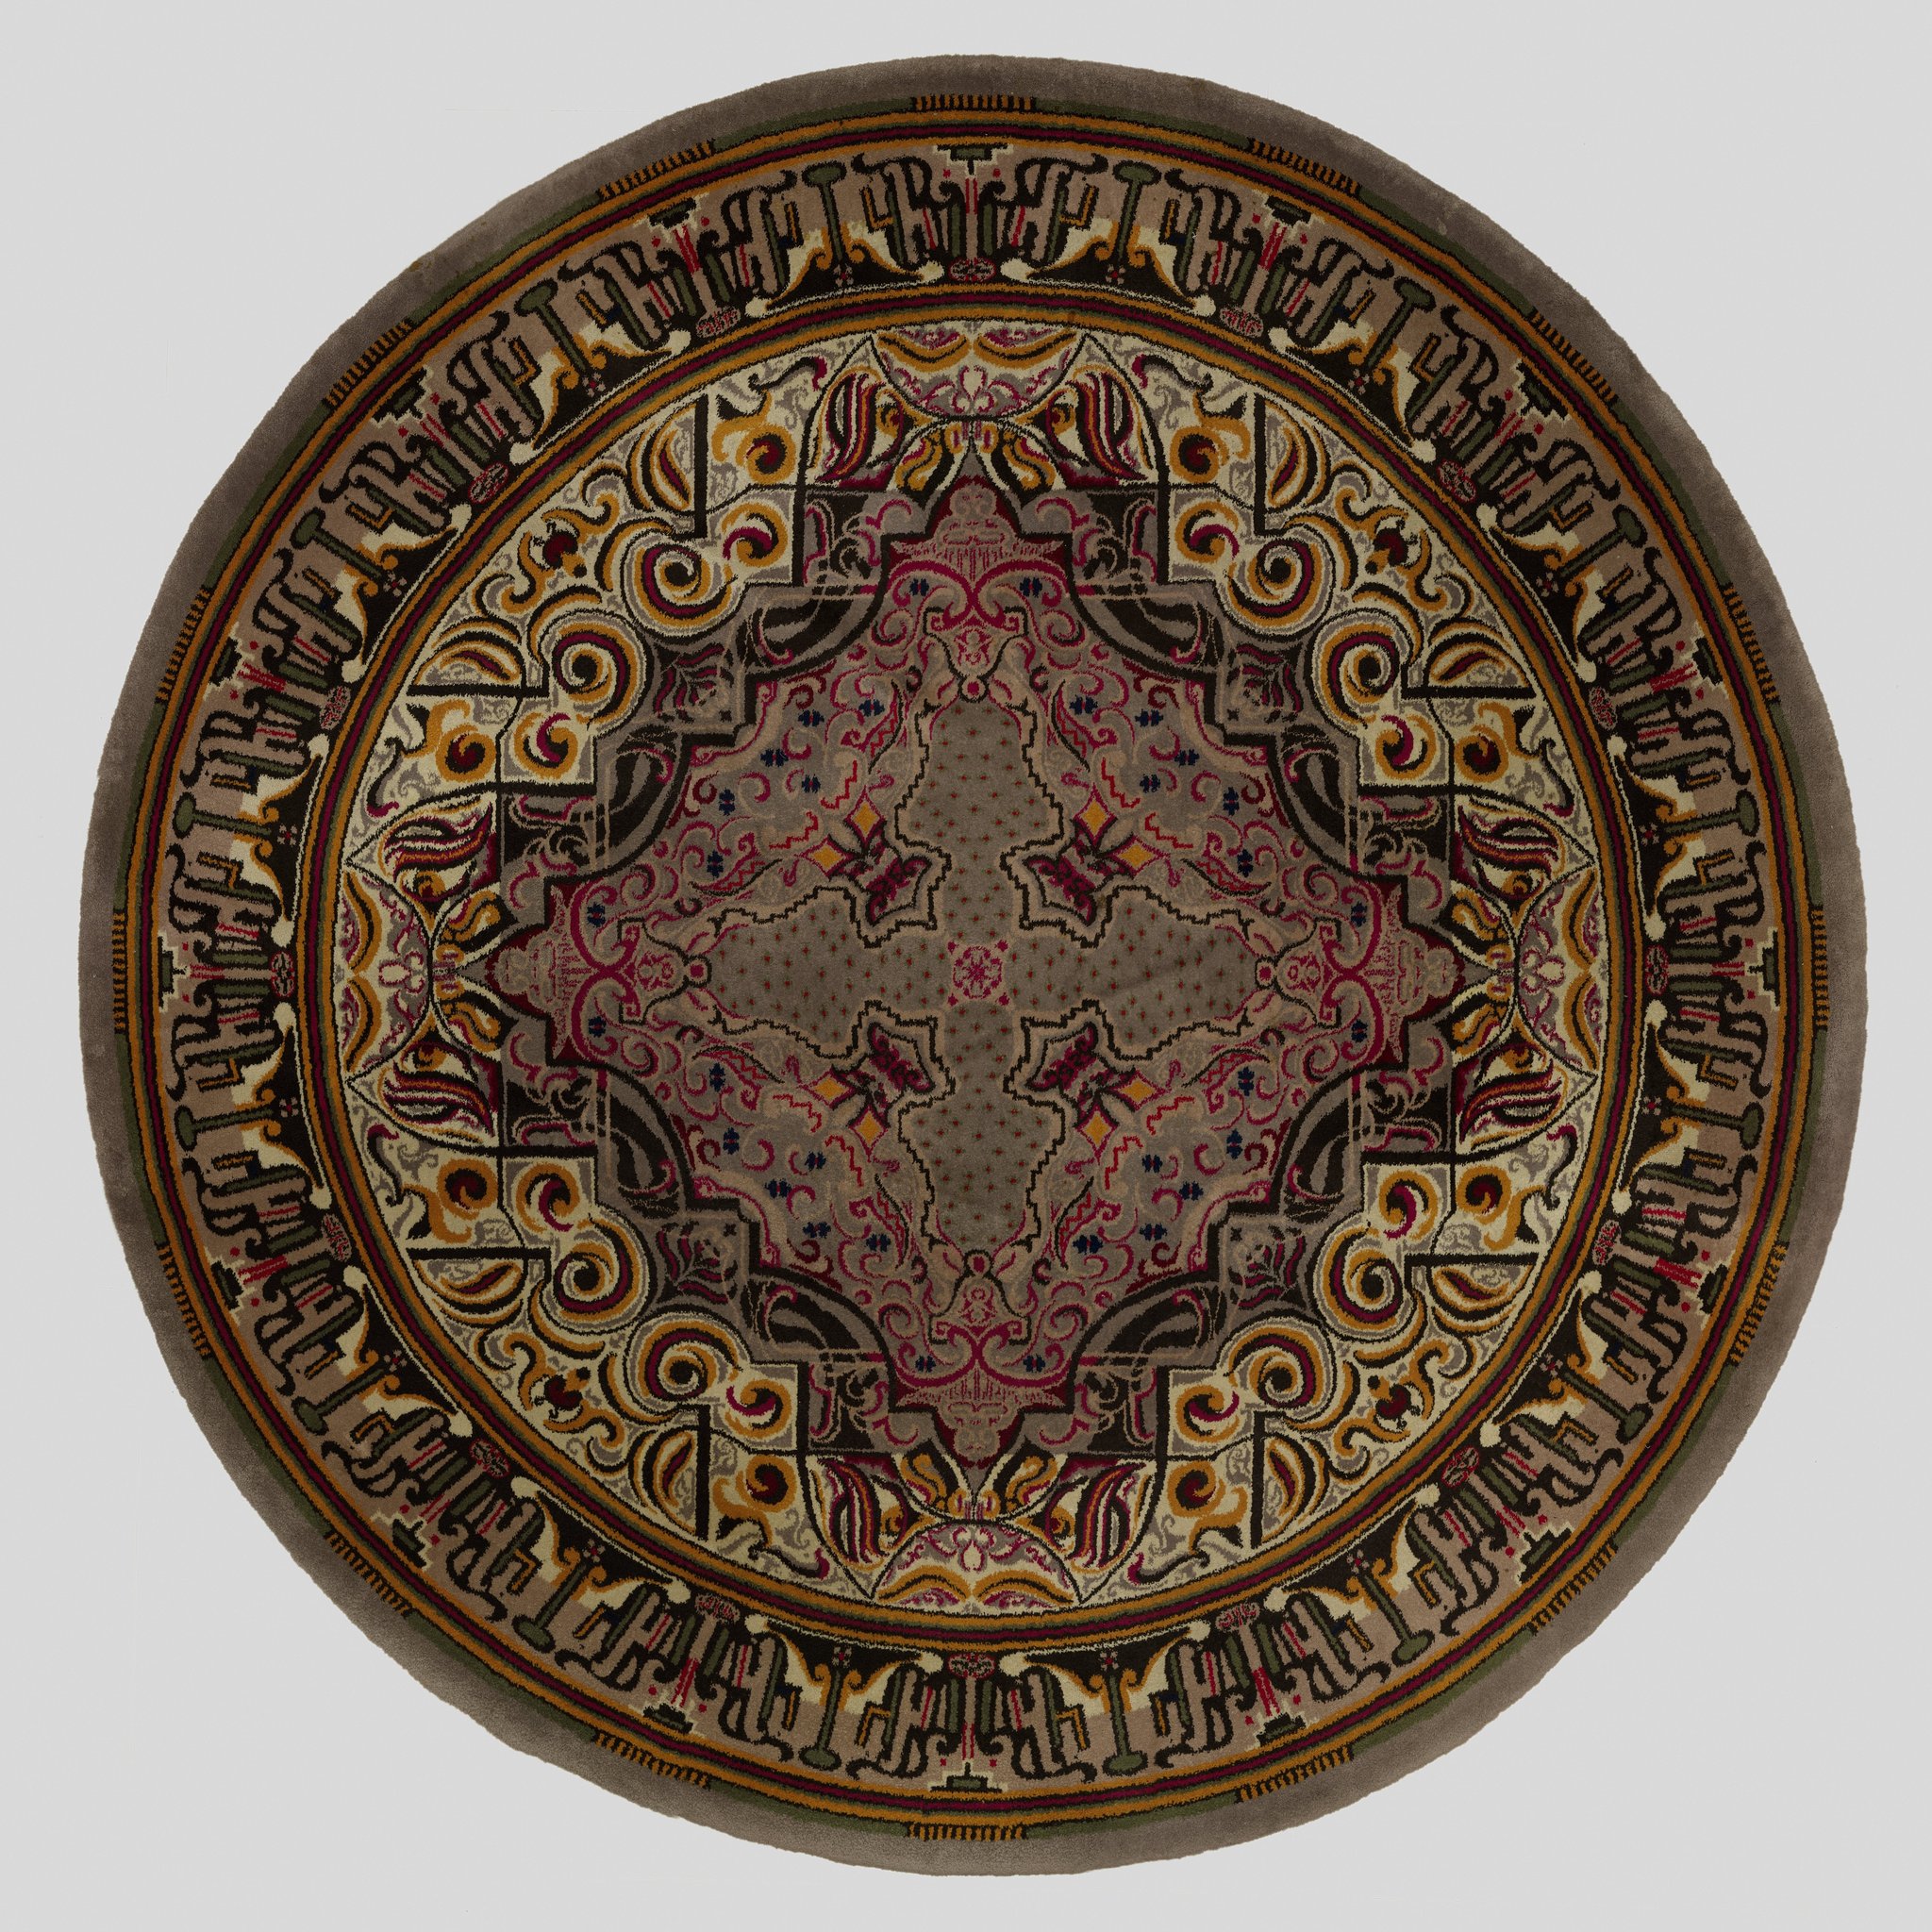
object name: carpet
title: Vloerkleed met geometrische figuren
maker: carel adolph lion cachet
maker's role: draughtsman, print maker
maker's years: 1864-1945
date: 1921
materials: wool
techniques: knotting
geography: rotterdam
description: Europees vloerkleed met geometrische figuren, ontworpen door C.A. Lion Cachet voor het s.s. Johan de Witt van de Mij. Nederland.